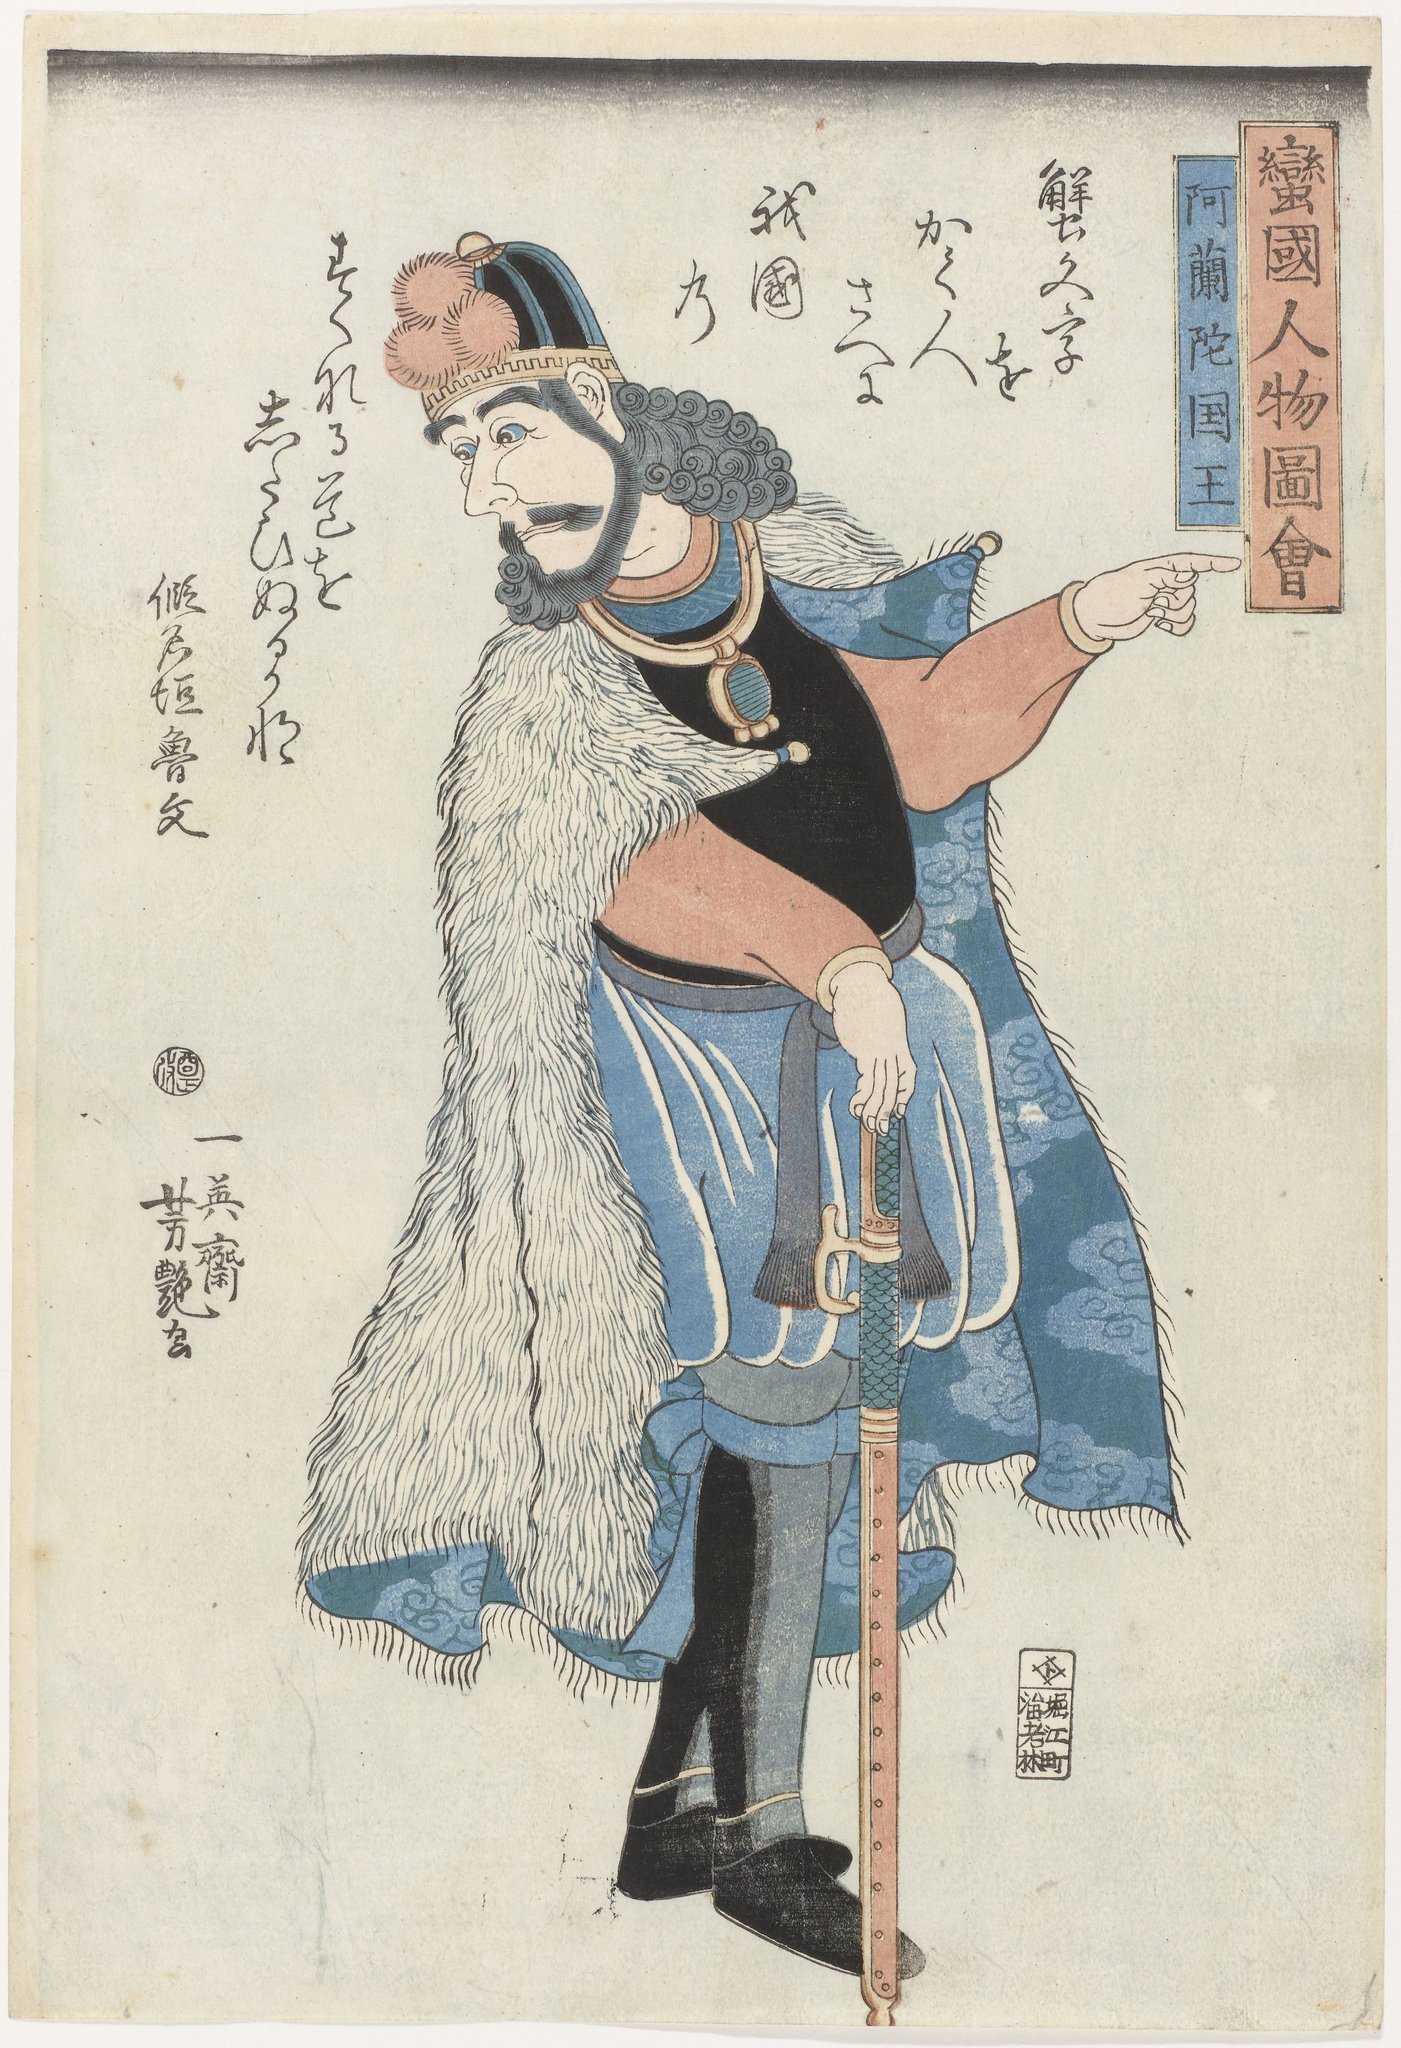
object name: print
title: The King of the Netherlands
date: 1861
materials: paper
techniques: colour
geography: japan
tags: standing figure, hacking and thrusting weapons: sword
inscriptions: poem, signature, signature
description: The Dutch were not always depicted with respect in Japan. Part of a series about people from foreign countries, this print portrays the king of the Netherlands accompanied by an inscription mocking Dutch handwriting. In Japan, European writing was sometimes compared to the horizontal marks left by crabs scuttling sideways.